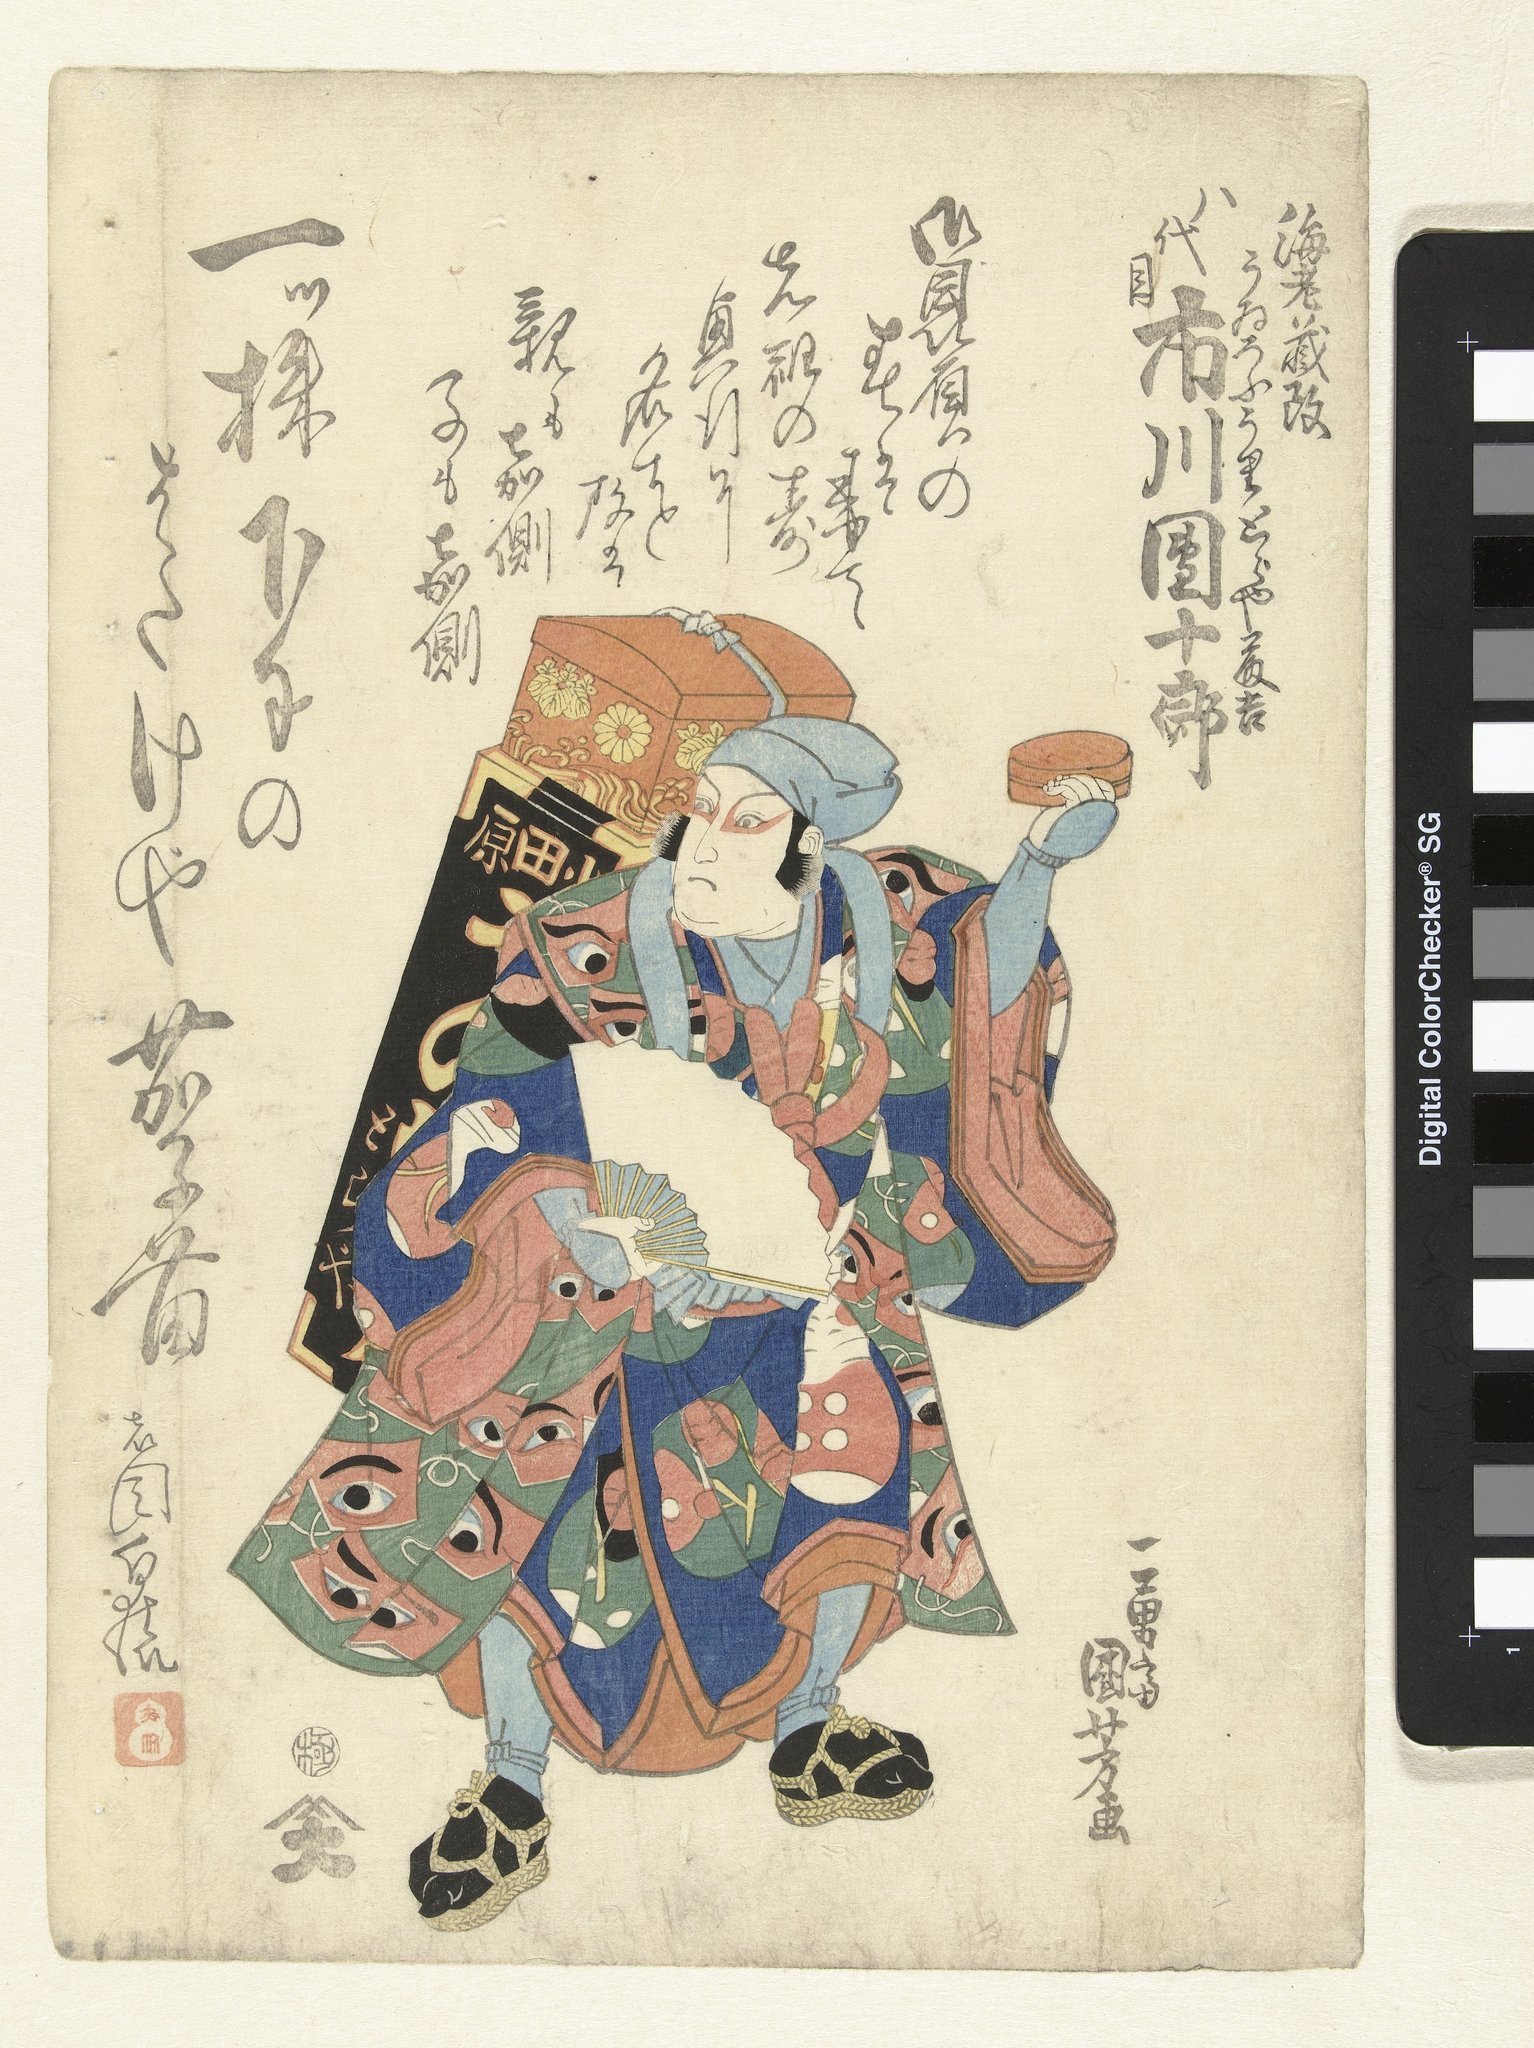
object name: print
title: Ichikawa Danjuru VII als marskramer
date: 1840-1850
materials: paper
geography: japan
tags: wandering or travelling merchant, portrait of actor, actress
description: De acteur Ichikawa Danjuro in de rol van marskramer, met waaier in linker hand.